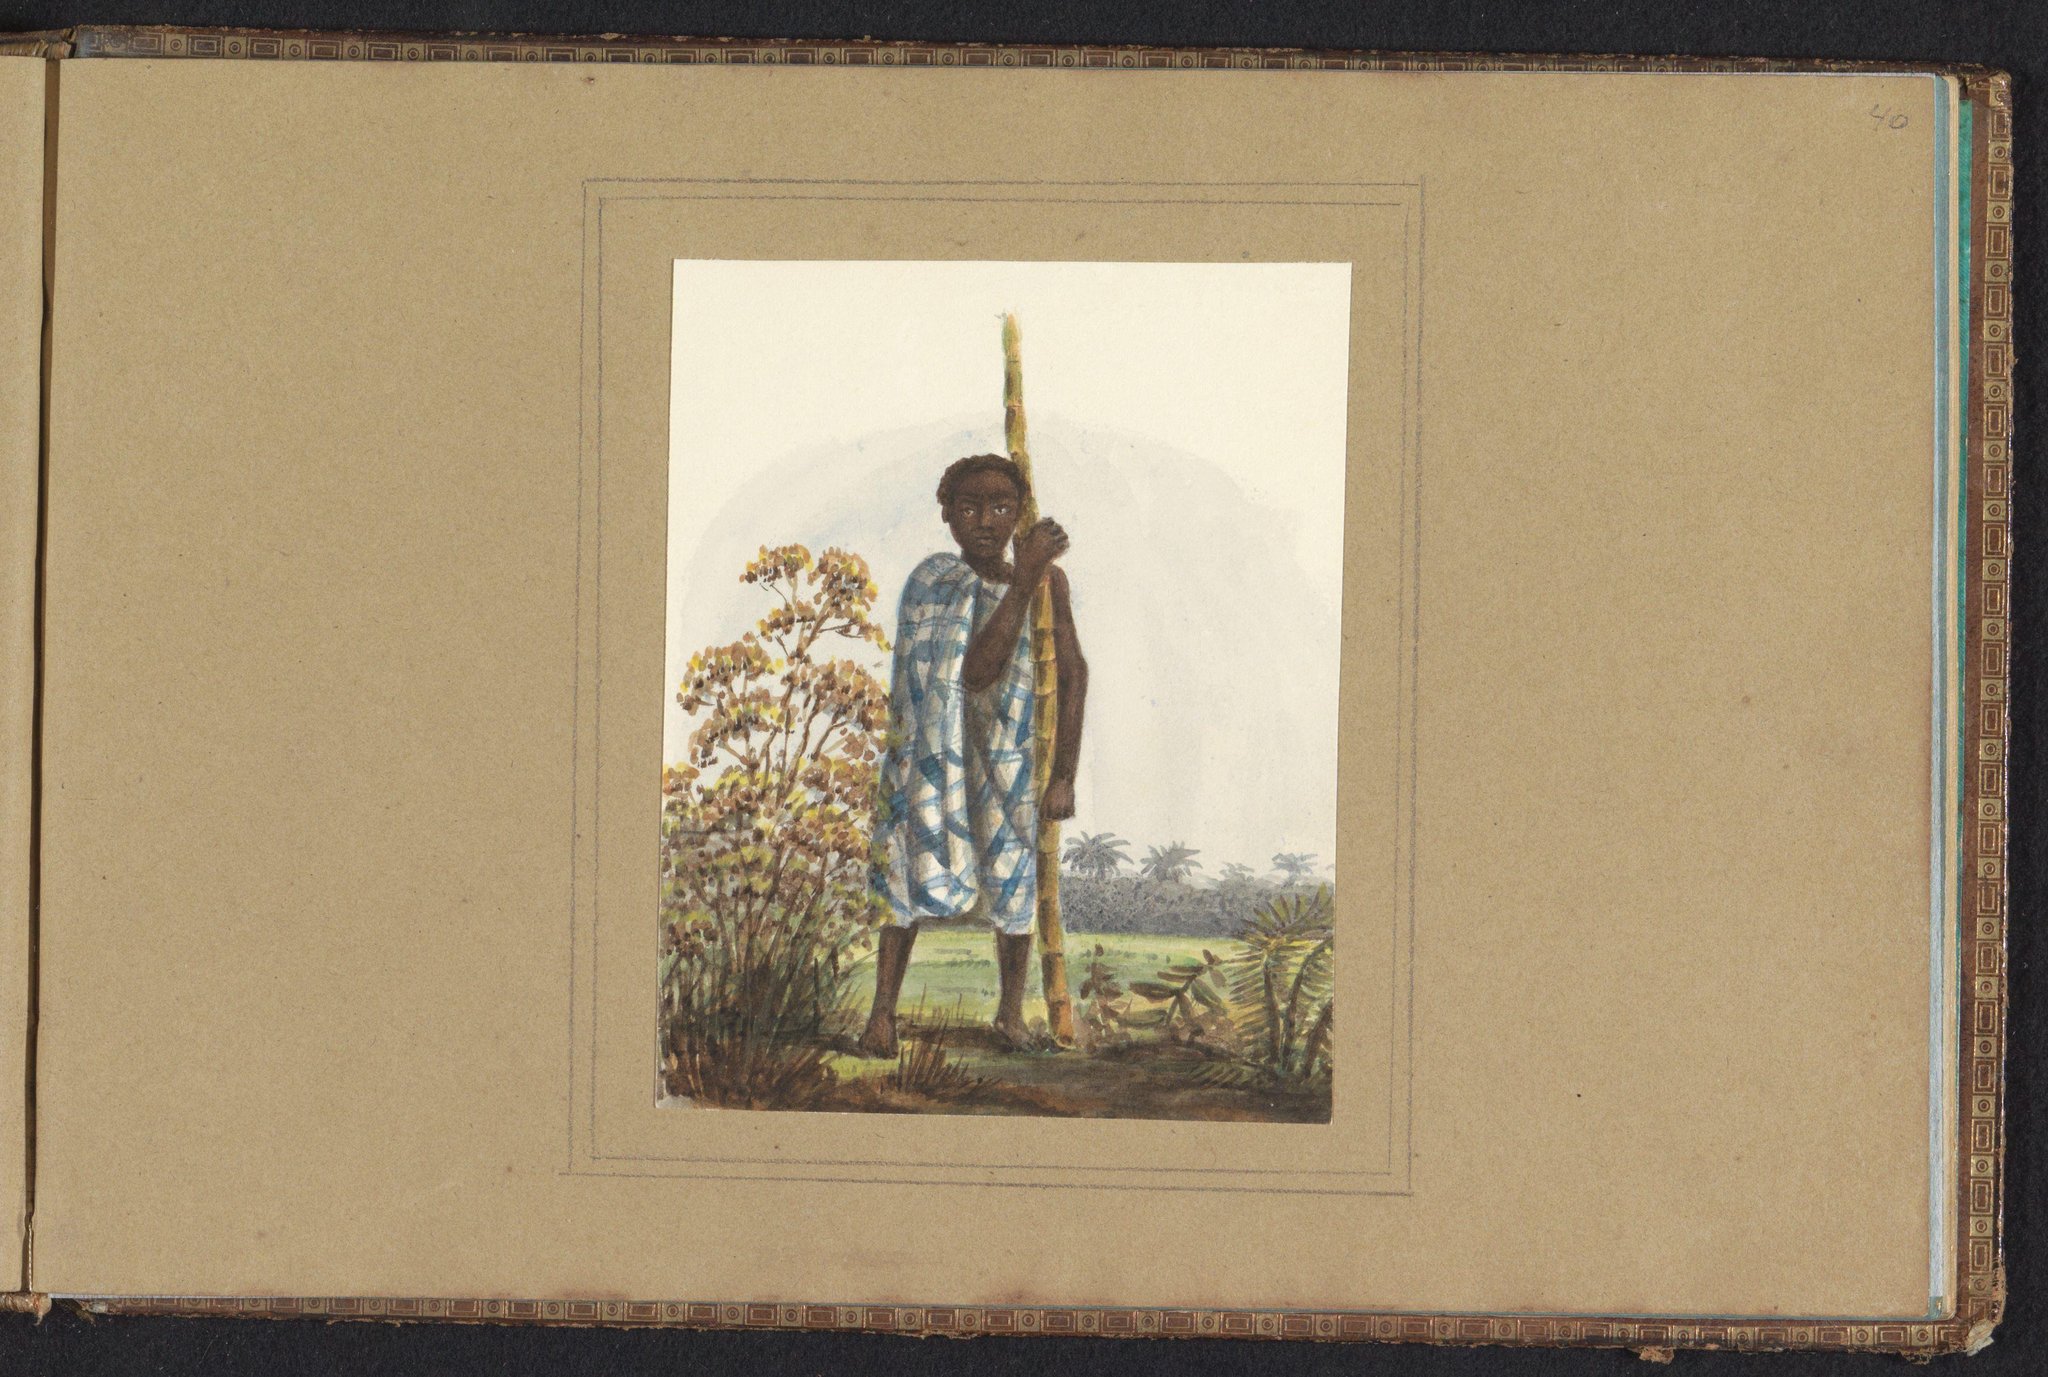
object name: kostuumstudie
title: Jongen met grote stengel suikerriet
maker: jacob marius adriaan martini van geffen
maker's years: 1821-1866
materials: ink, paper, pencil, watercolor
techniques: brush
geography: suriname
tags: africans, (non-fruit) products of plants or trees: sugarcane, slavery; serfs and enslaved persons, suriname